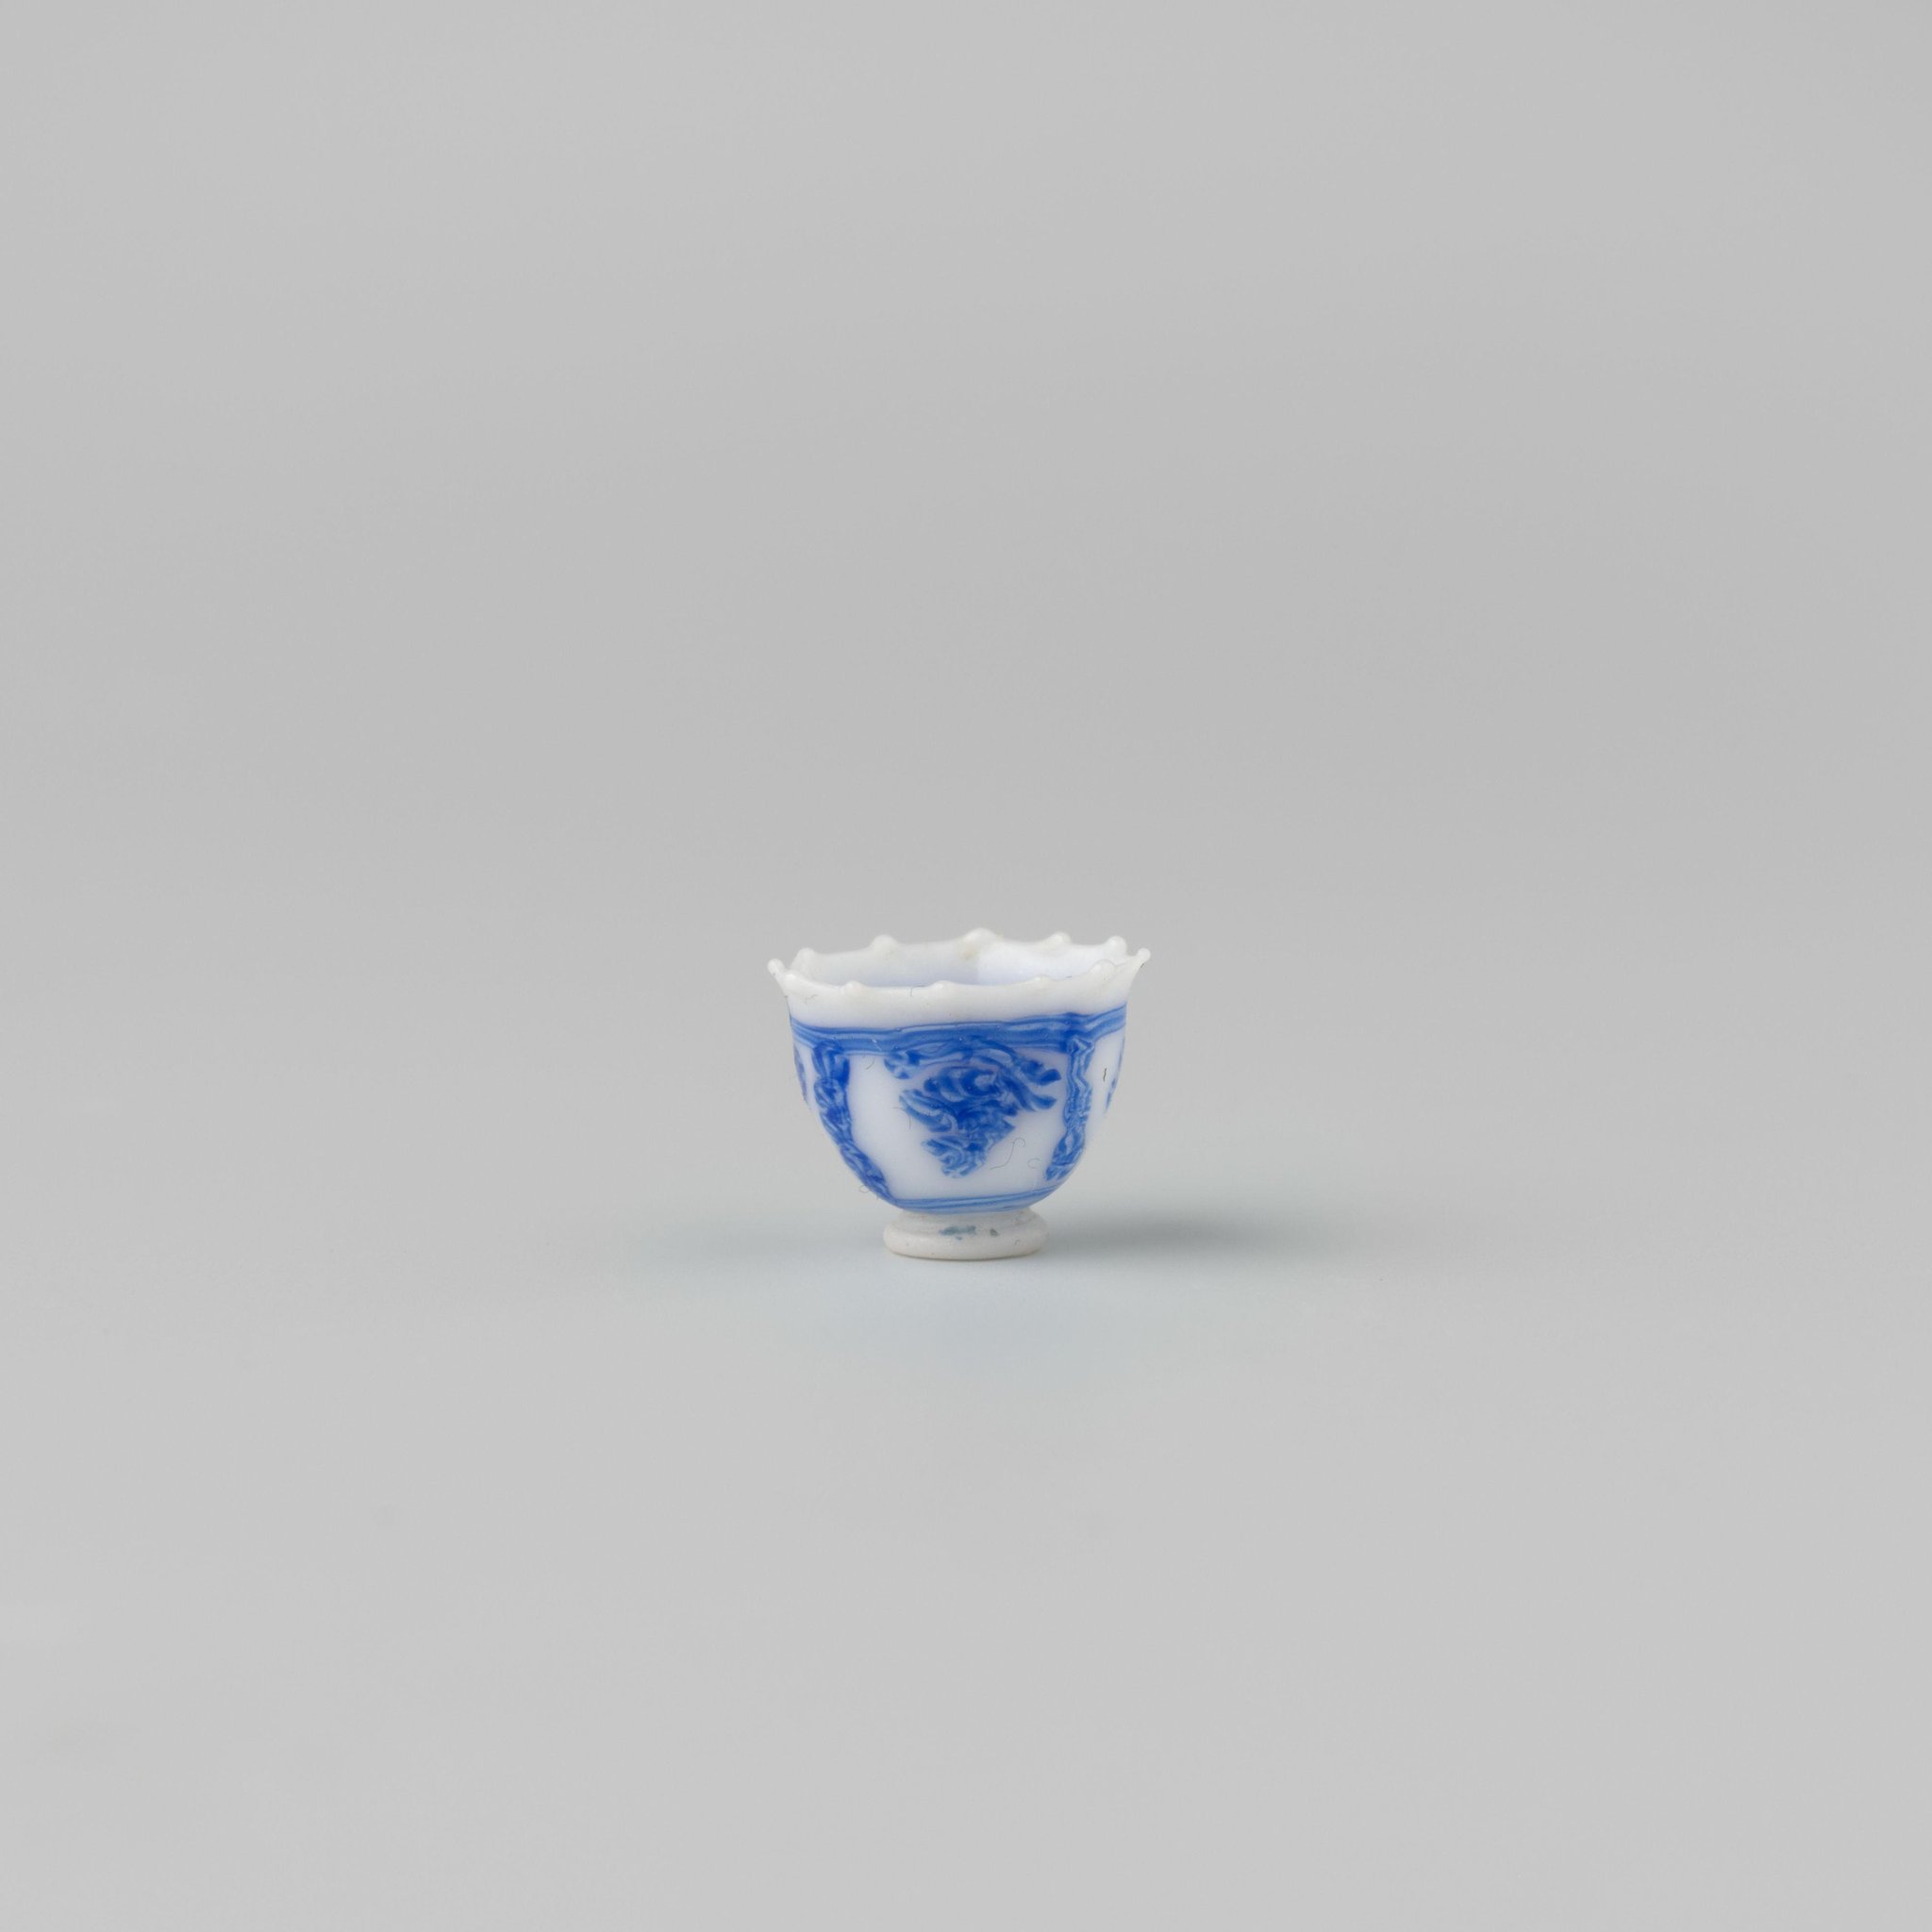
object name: cup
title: Theekopje van melkglas met blauwe emailverf beschildering, imitatie Chinees porselein met 'bloem' decoratie in vakken; model op los aangebrachte standring en met puntrand.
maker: Anonymous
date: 1675-1710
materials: glass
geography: amsterdam